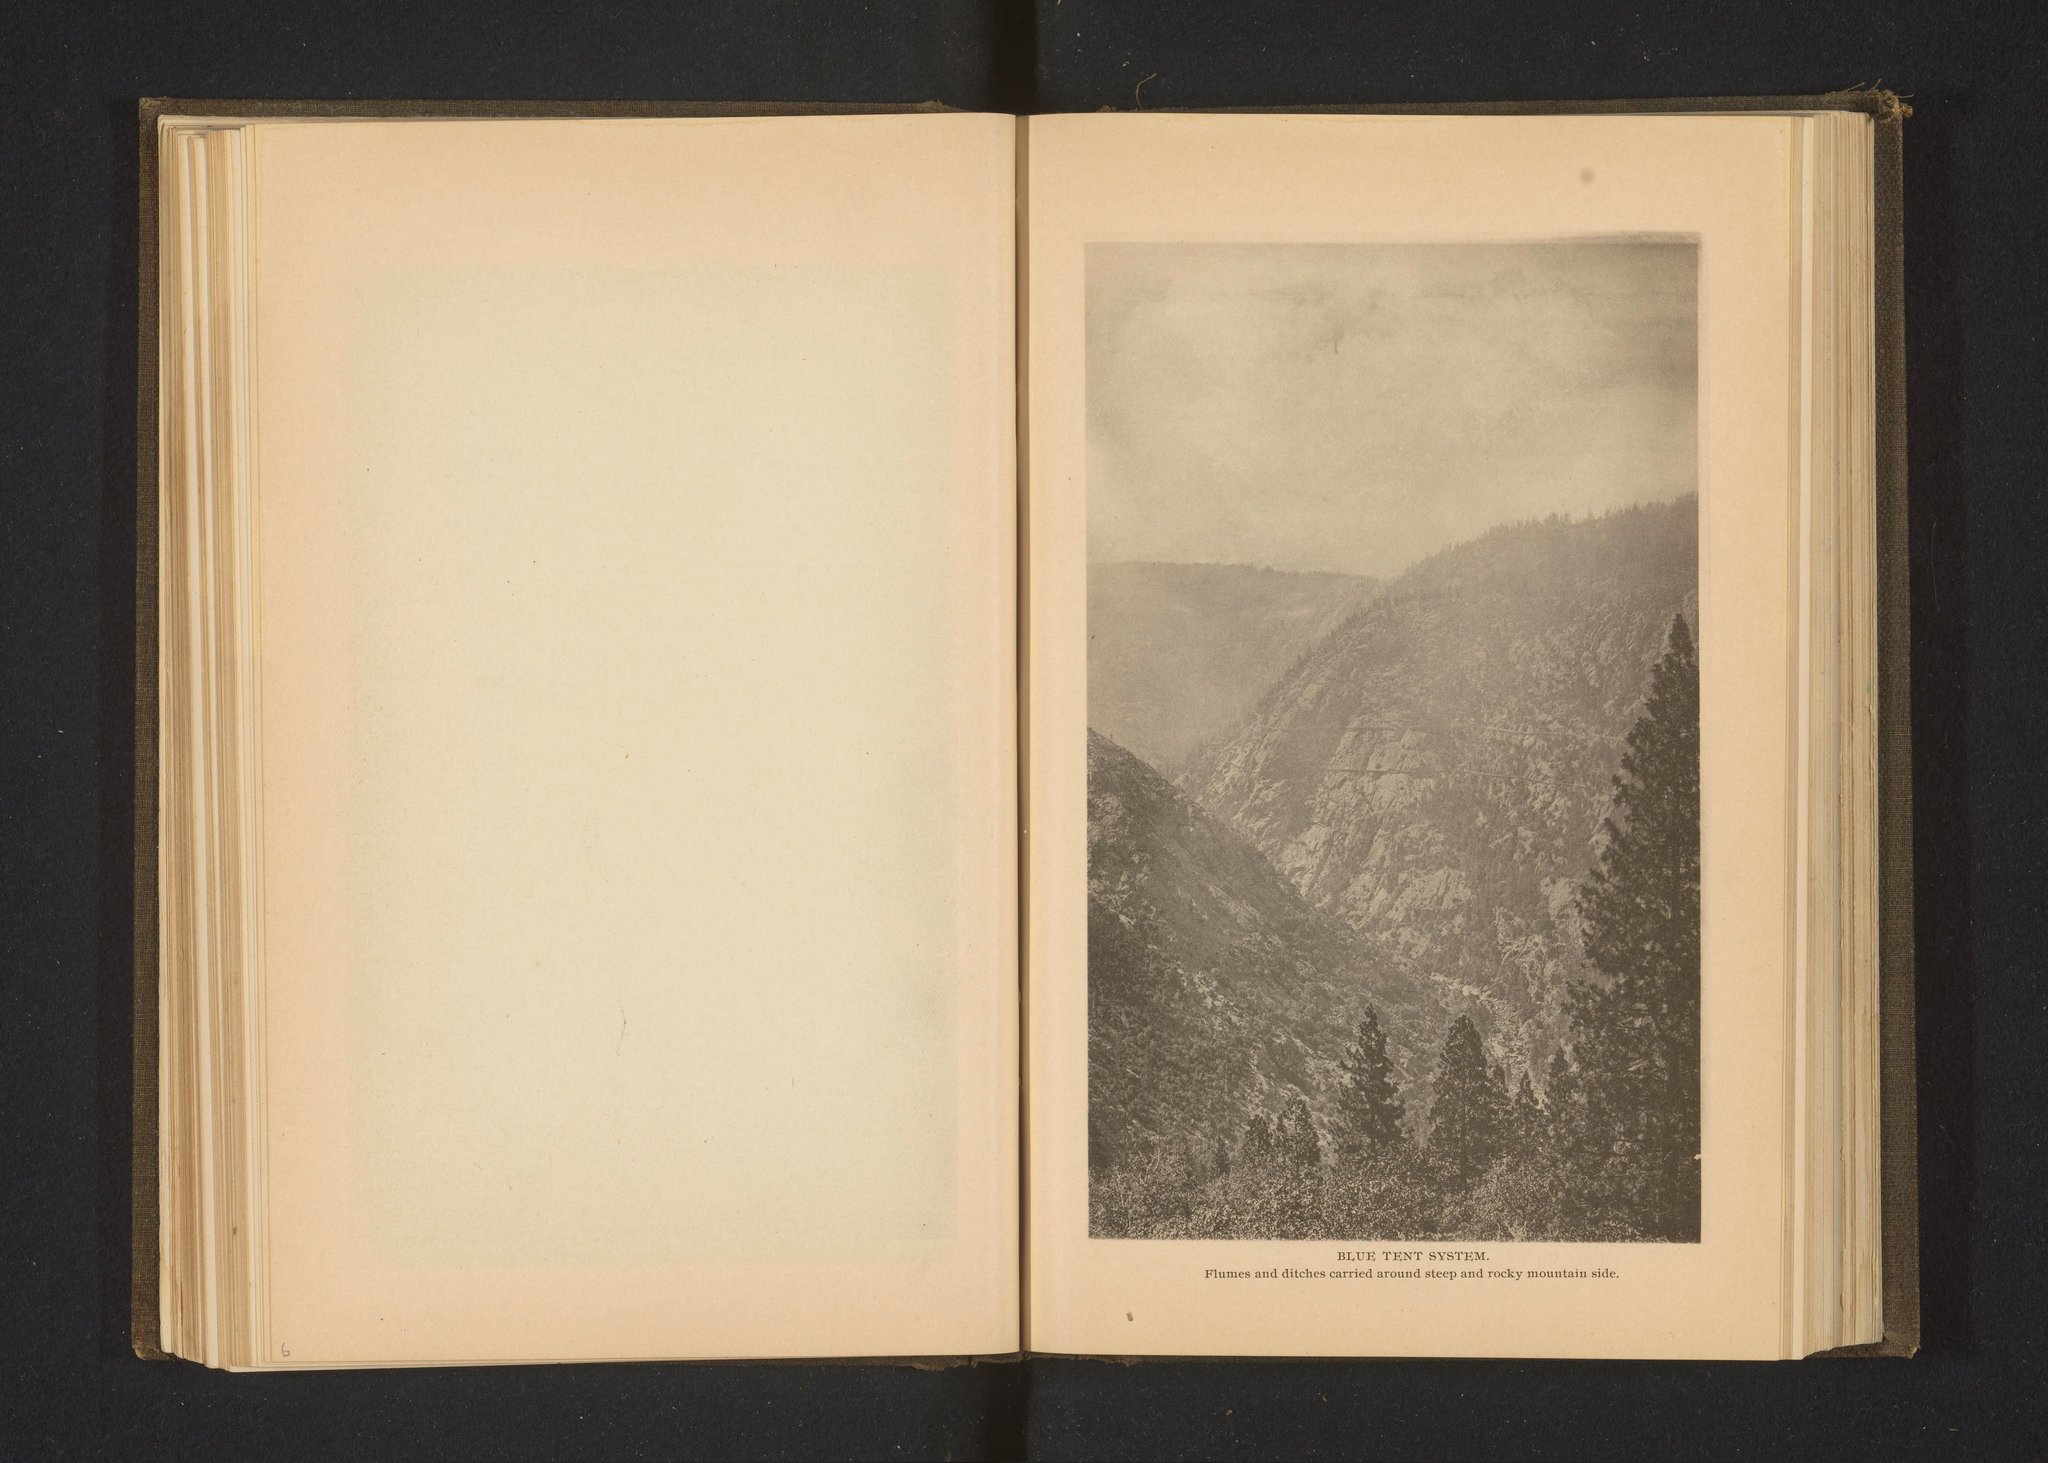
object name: photomechanical print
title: Blue Tent System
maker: Anonymous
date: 1885-1890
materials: paper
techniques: photograph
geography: nevada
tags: mountains, mine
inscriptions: inscription: ‘Flumes and ditches carried around steep and rocky mountain side.’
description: Prent op derde ongenummerde pagina na pagina 122.